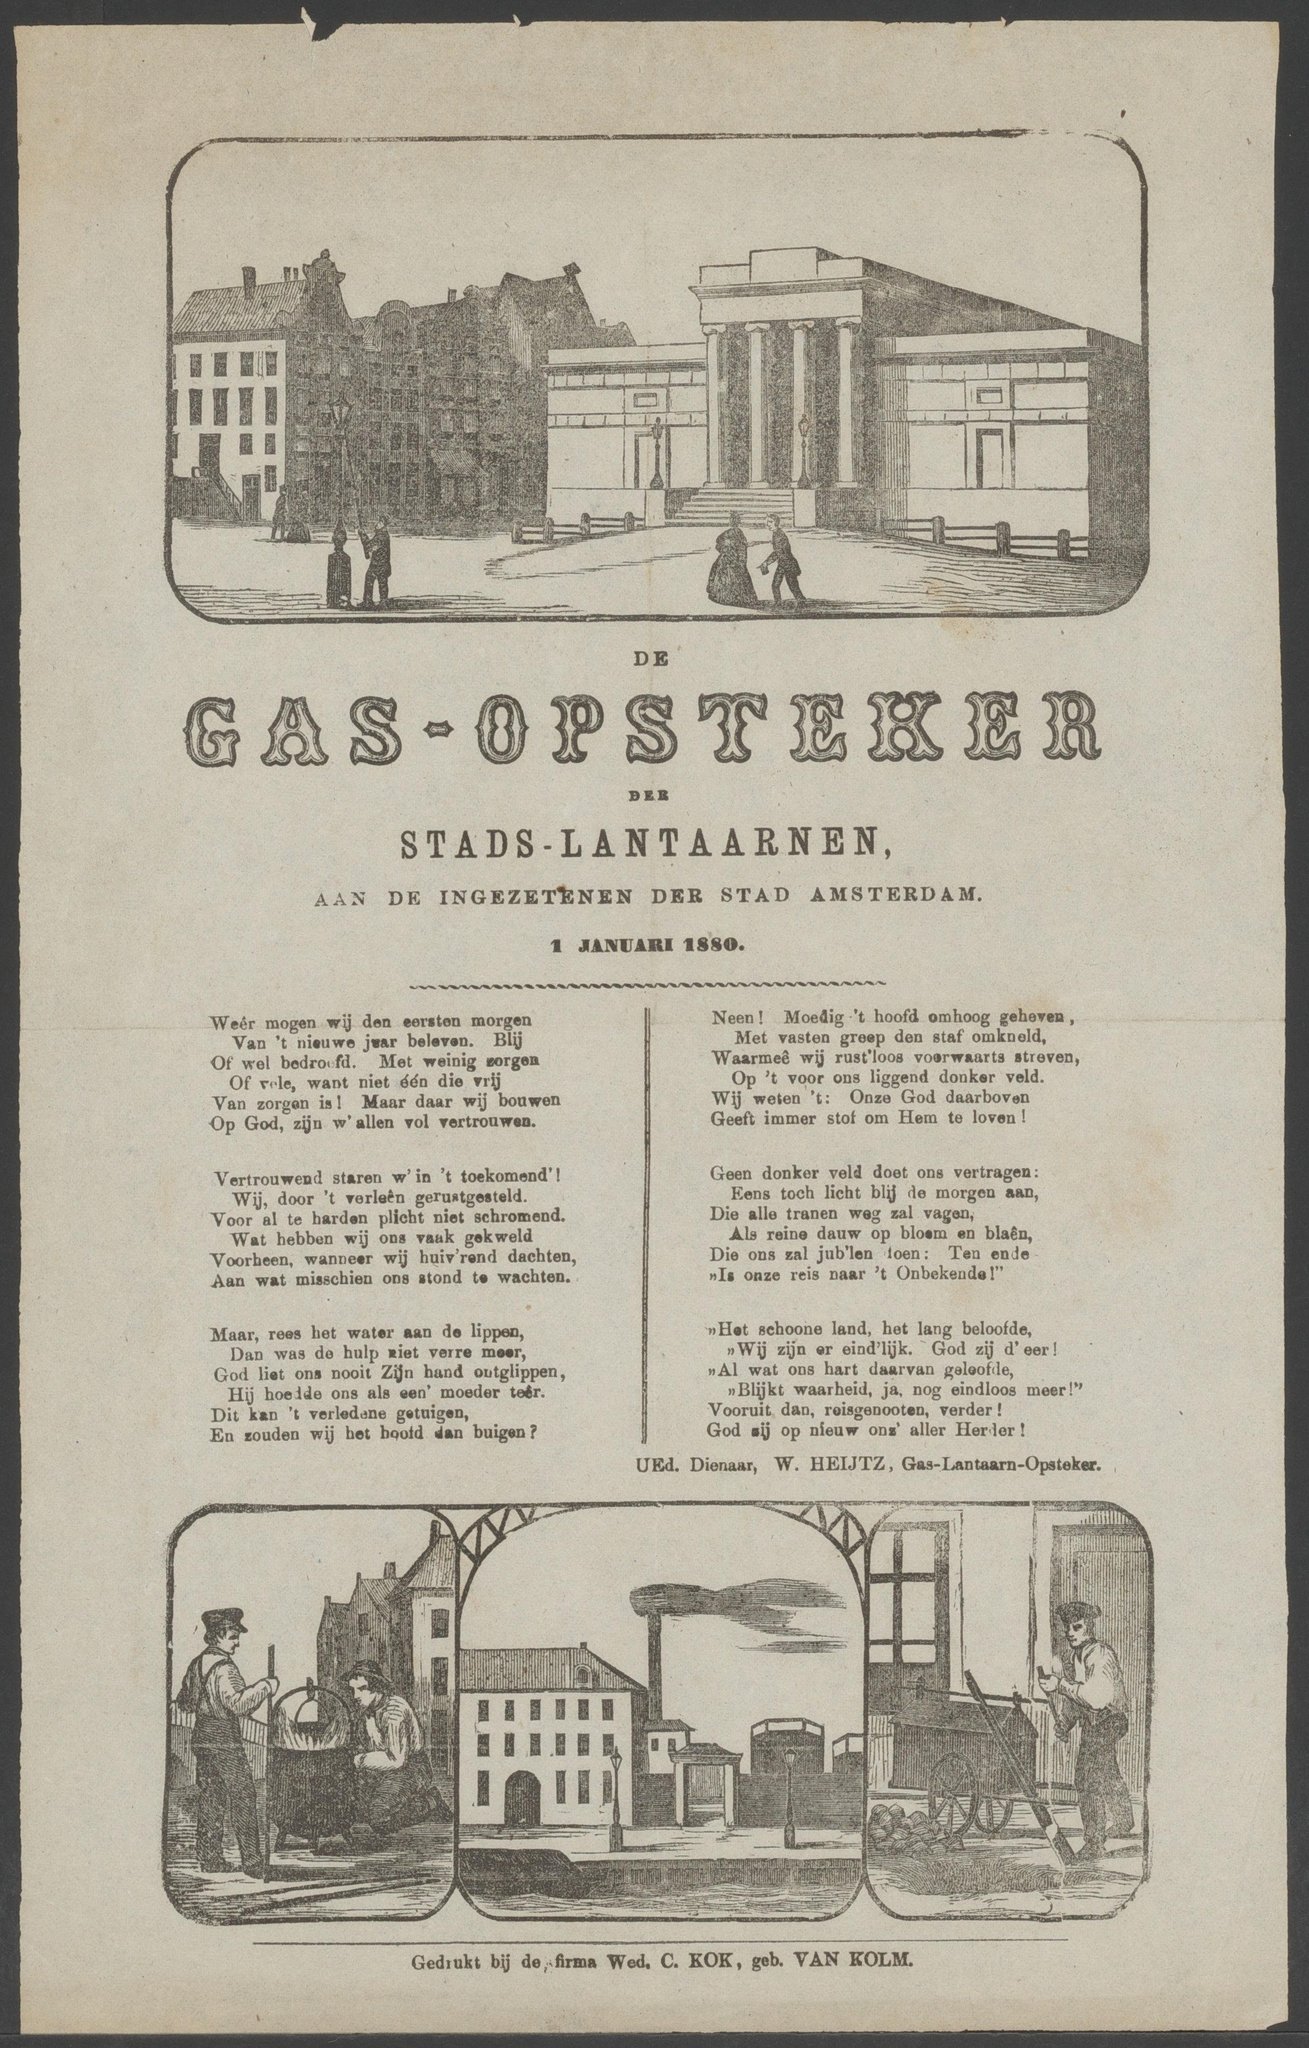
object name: print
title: De Gas-opsteker der Stads-lantaarnen, aan de ingezetenen der stad Amsterdam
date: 1879-1880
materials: paper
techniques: letterpress printing, engraving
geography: amsterdam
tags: gas-lamp, gas supply, digging (industrial process), street lighting, amsterdam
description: Nieuwjaarswens van de Amsterdamse gaslantaarnopstekers voor het jaar 1880. Centraal een vers in twee kolommen. Bovenaan de Dam met de beurs van Zocher te Amsterdam. Onderaan de Hollandsche Gasfabriek en twee gasfitters aan het werk. Van de gaslantaarnopsteker: W. Heijtz. Onderwerpsrubrieken binnen de Atlas Zeden en Gewoonten: Zeden en gewoonten in engeren zin, Volksleven, Volksbladen, Nieuwjaars- en Kerstwenschen, Amsterdam.